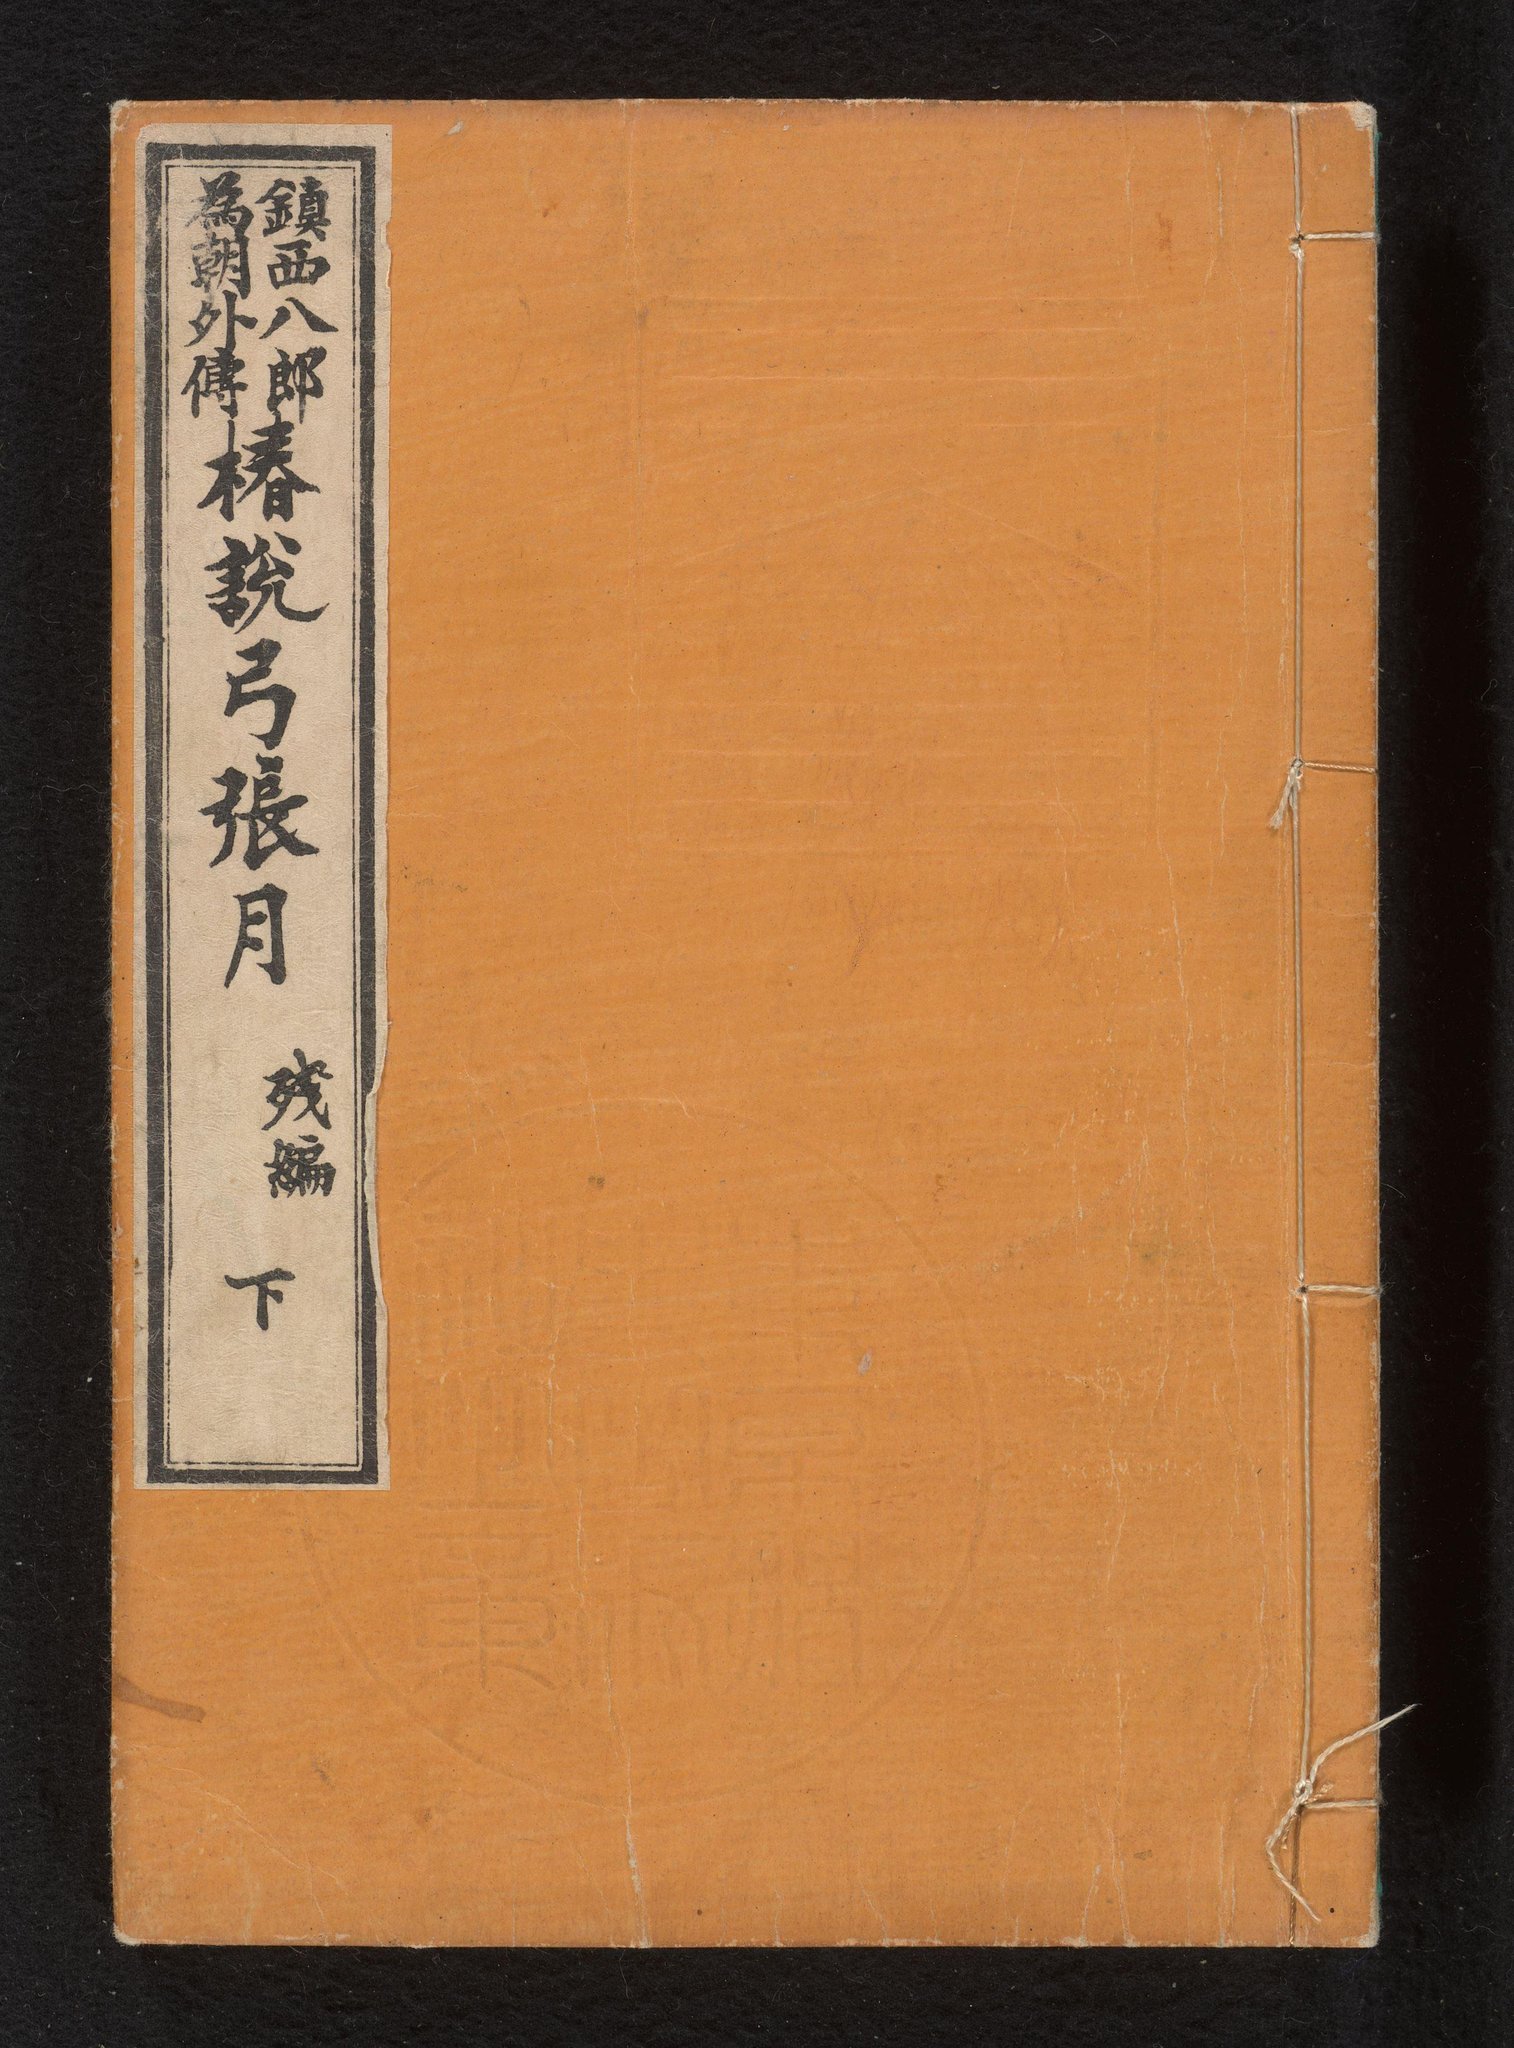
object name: book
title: De wassende maan, overige boeken, deel 2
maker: tsukioka yoshitoshi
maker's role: print maker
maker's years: 1839-1892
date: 1883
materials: paper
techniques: blind stamped, lithograph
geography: japan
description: Boek uit een tiendelige serie over de avonturen van de legendarische strijder Tametomo, geïllustreerd met 26 prenten gesigneerd door Tsukioka Yoshitoshi. De prenten zijn uitgevoerd in een combinatie van houtsnede en lithografie en gedrukt in zwart met een grijs toonblok. In originele banden met blinddruk.